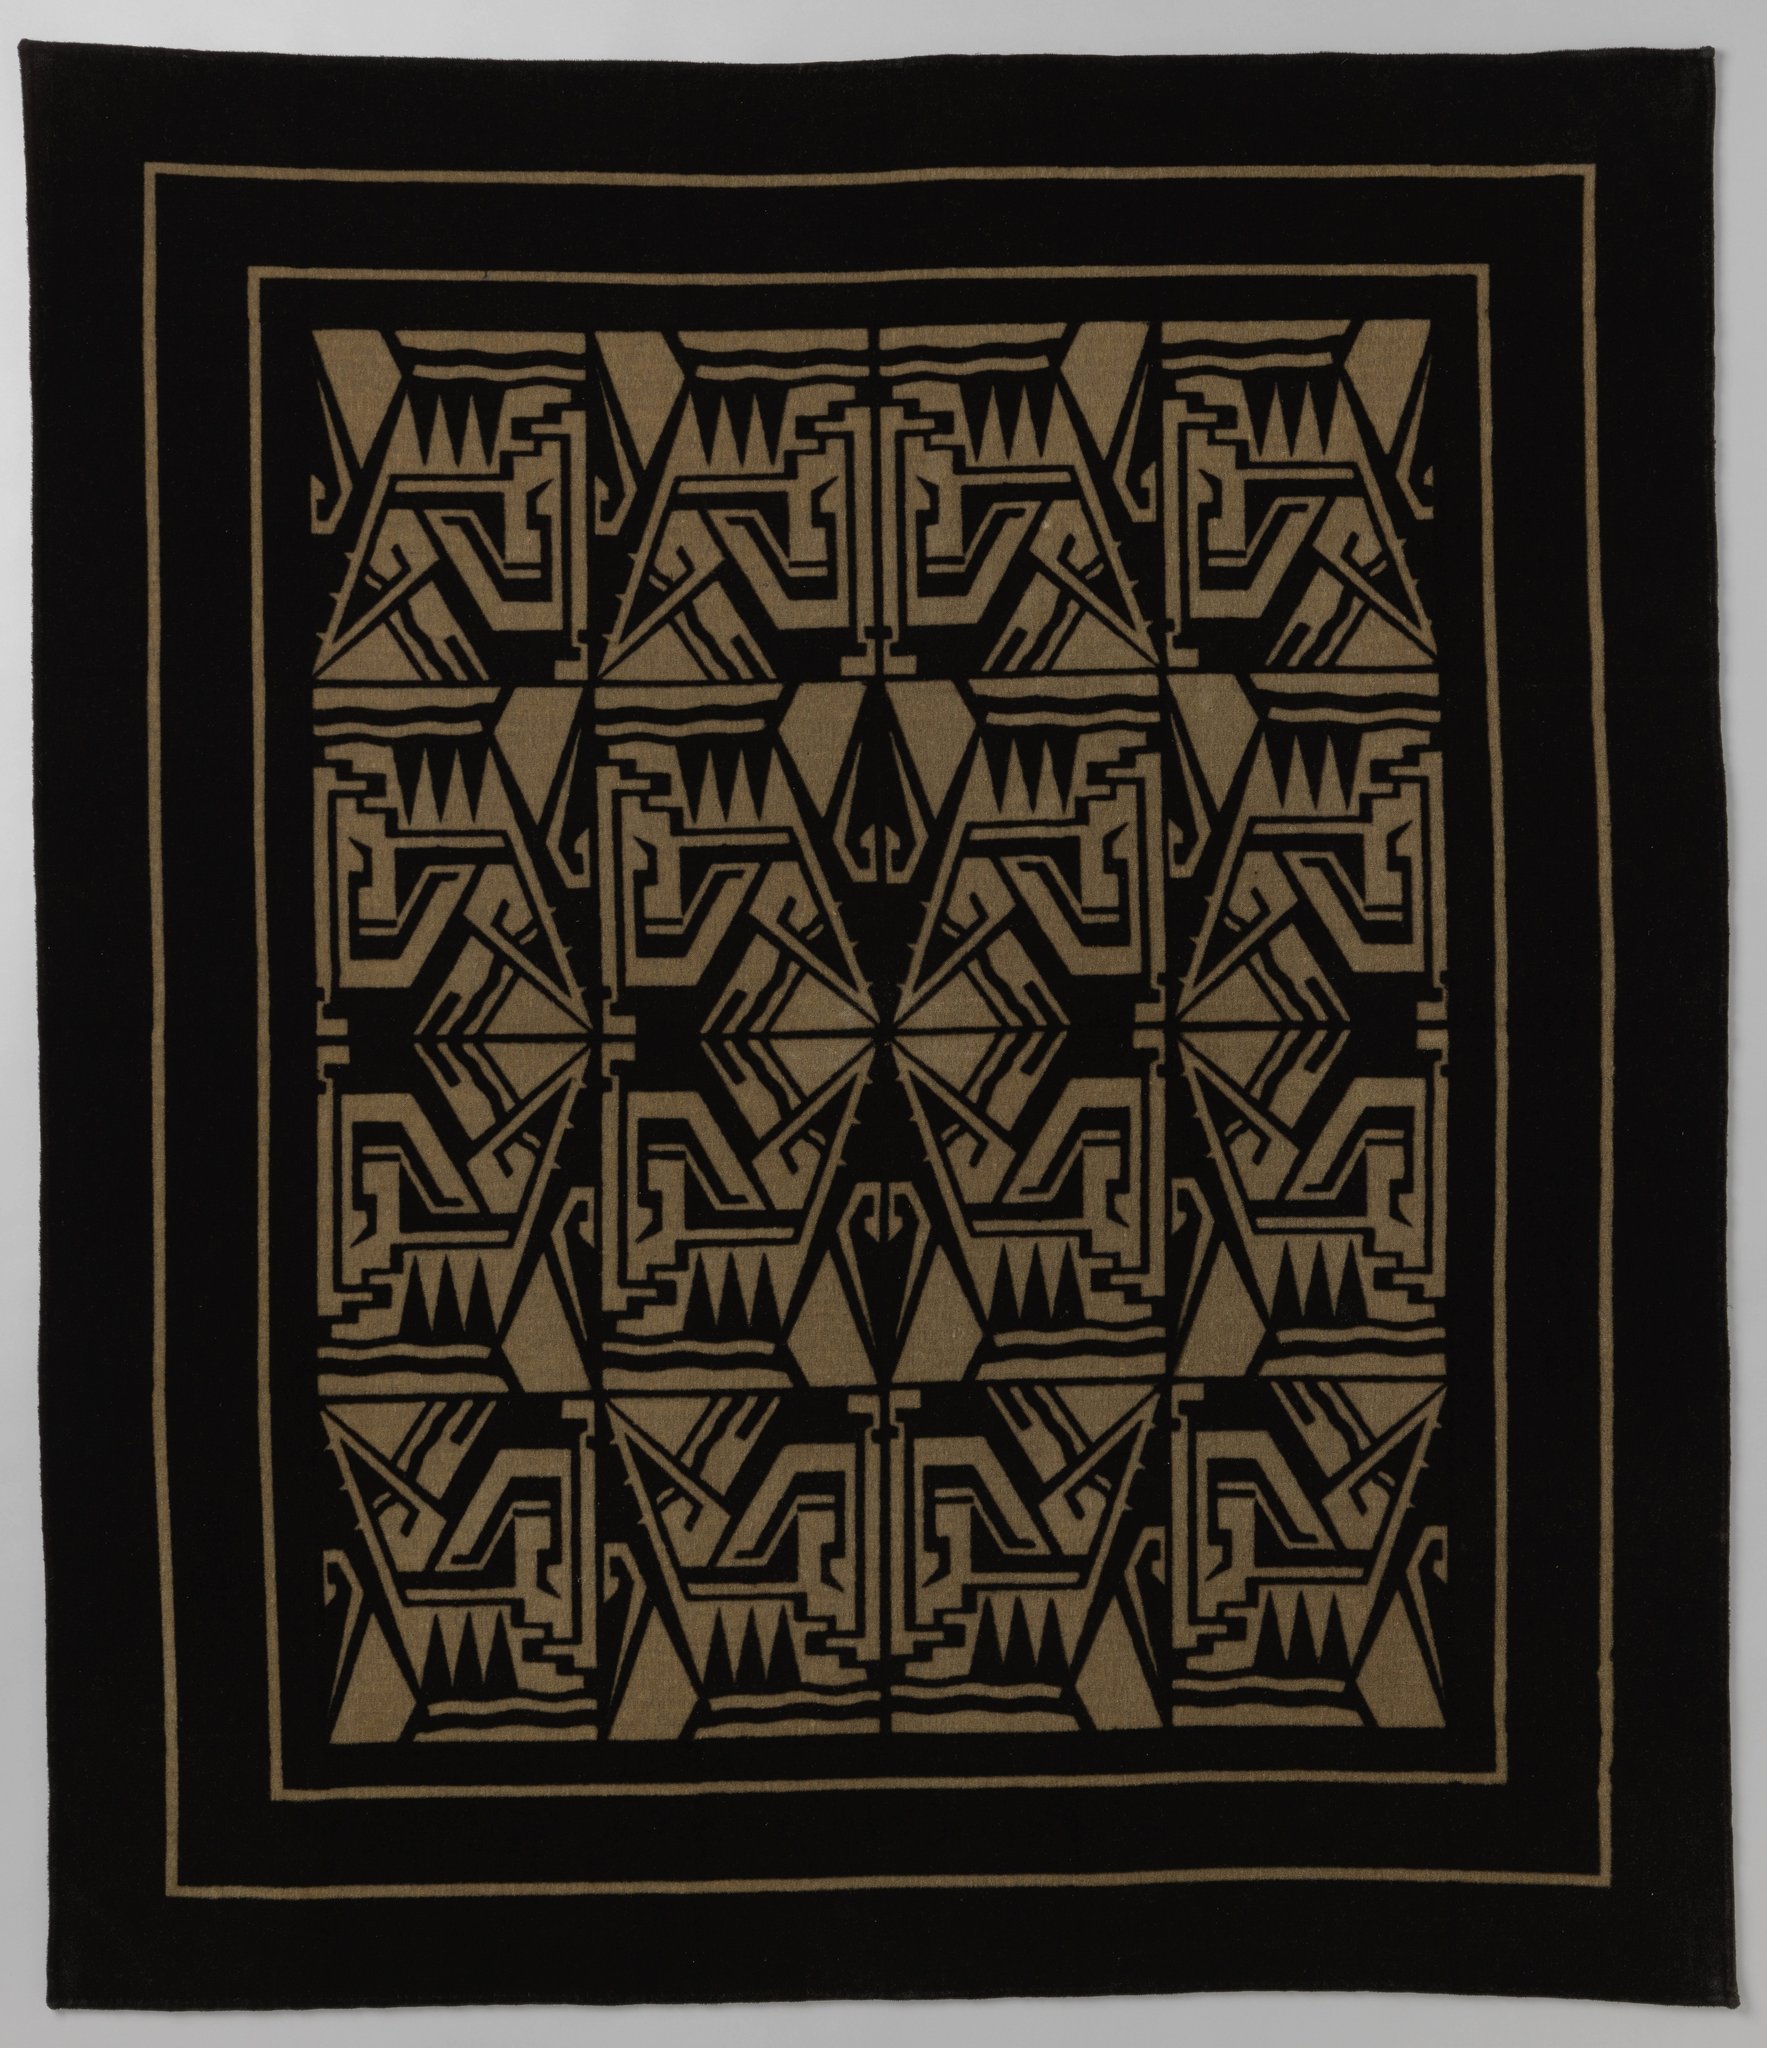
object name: tafelkleed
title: Tafelkleed van bedrukte trijp in zwart en beige met Art-Déco patroon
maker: Anonymous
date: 1920-1930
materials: cotton, textile, hair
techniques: printing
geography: netherlands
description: Tafelkleed van bedrukte trijp met Art-Déco patroon, bestaande uit geometrische vormen in beige op een zwart fond.